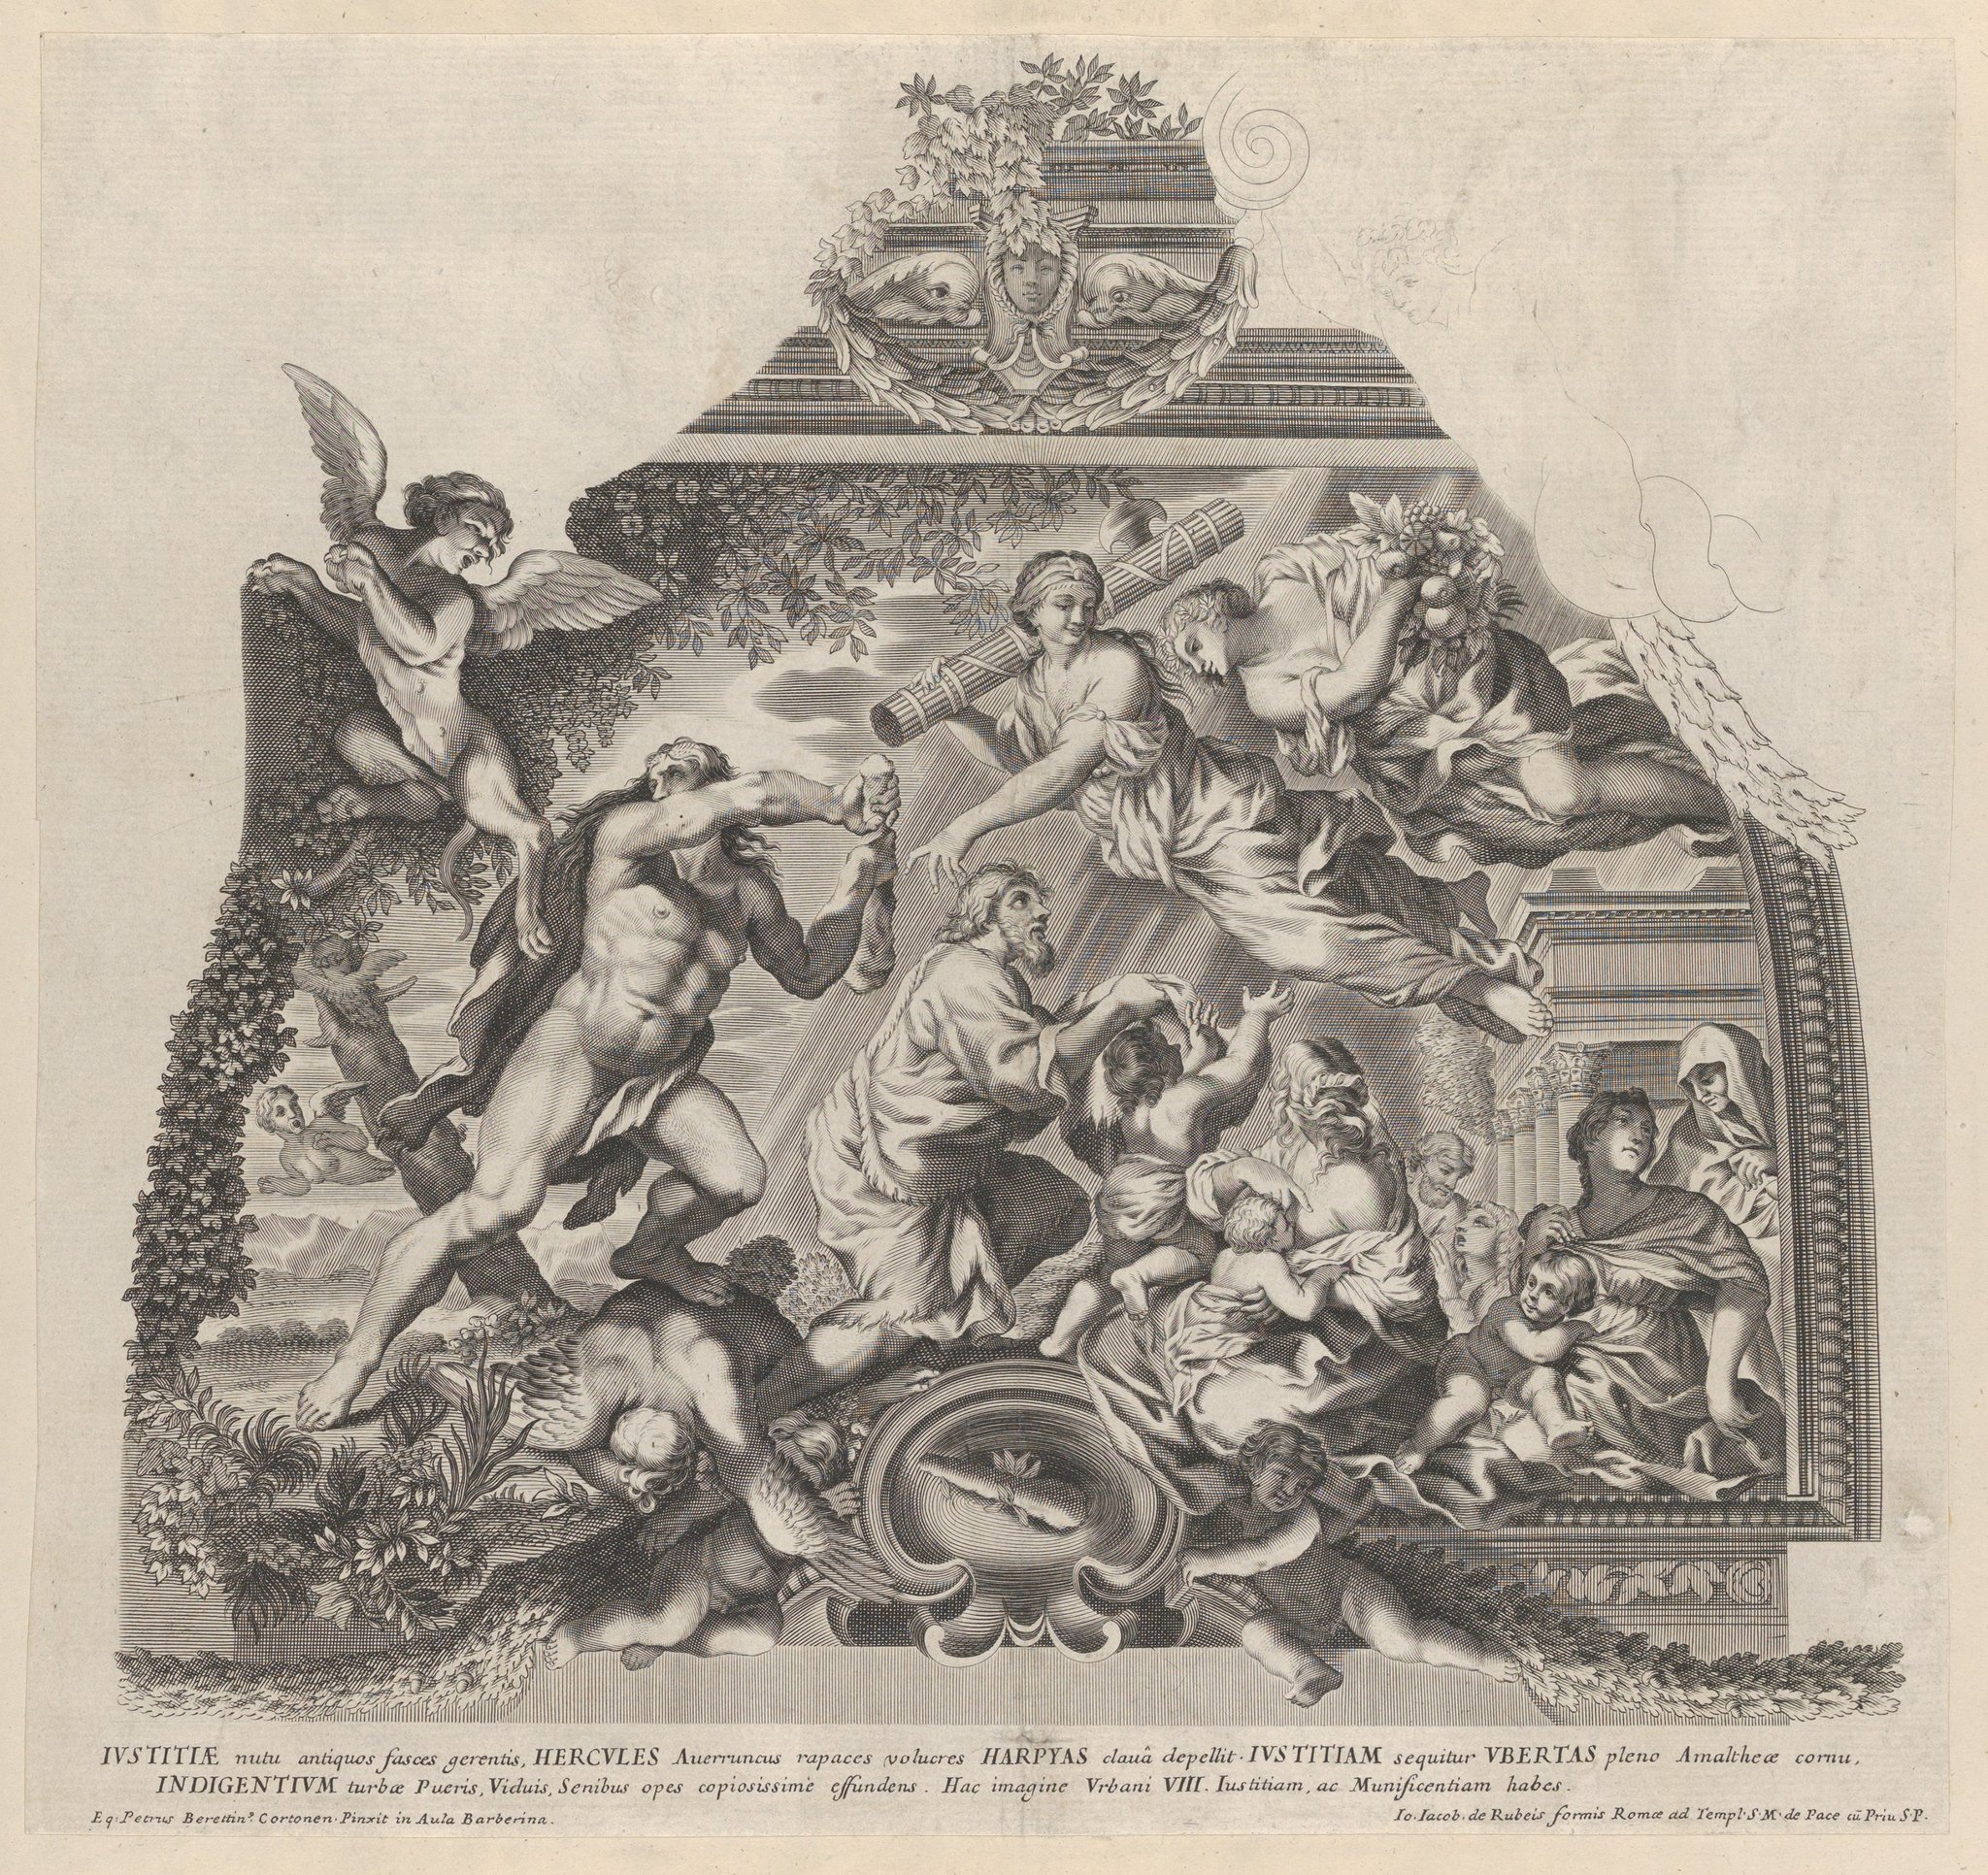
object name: print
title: Plate 6: Allegory with Hercules chasing off the Harpies as Justice and Plenty aid the poor, from "Barberinae aulae fornix"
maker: anonymous, italian, 17th century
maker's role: artist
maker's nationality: italian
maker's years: 1600-1700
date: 1677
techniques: engraving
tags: men,women,hercules